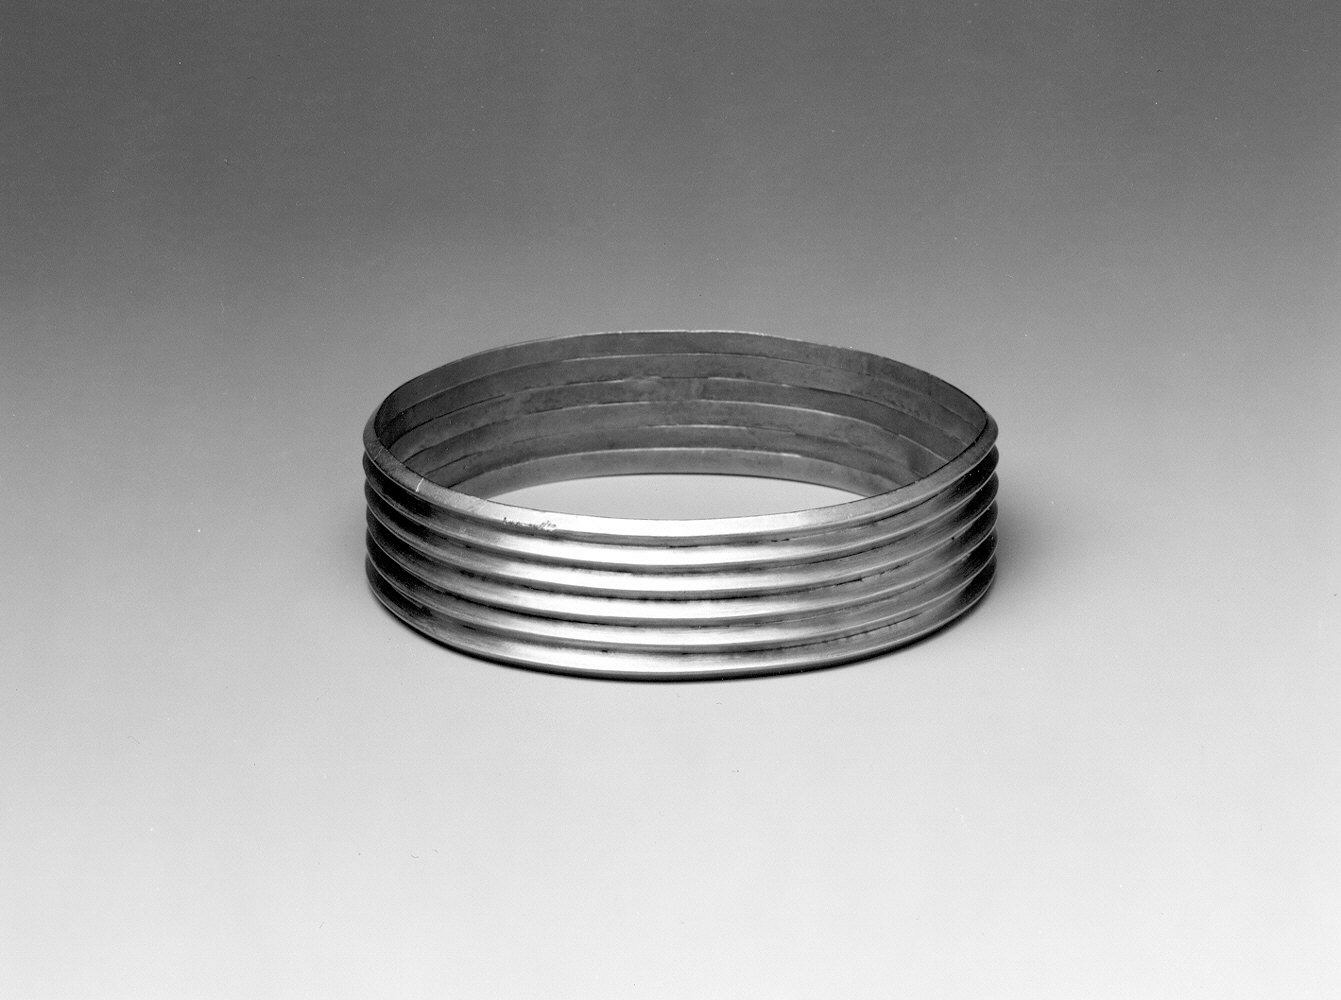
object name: armlet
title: Pair of armlets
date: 500-301 BCE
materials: gold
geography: iberian peninsula